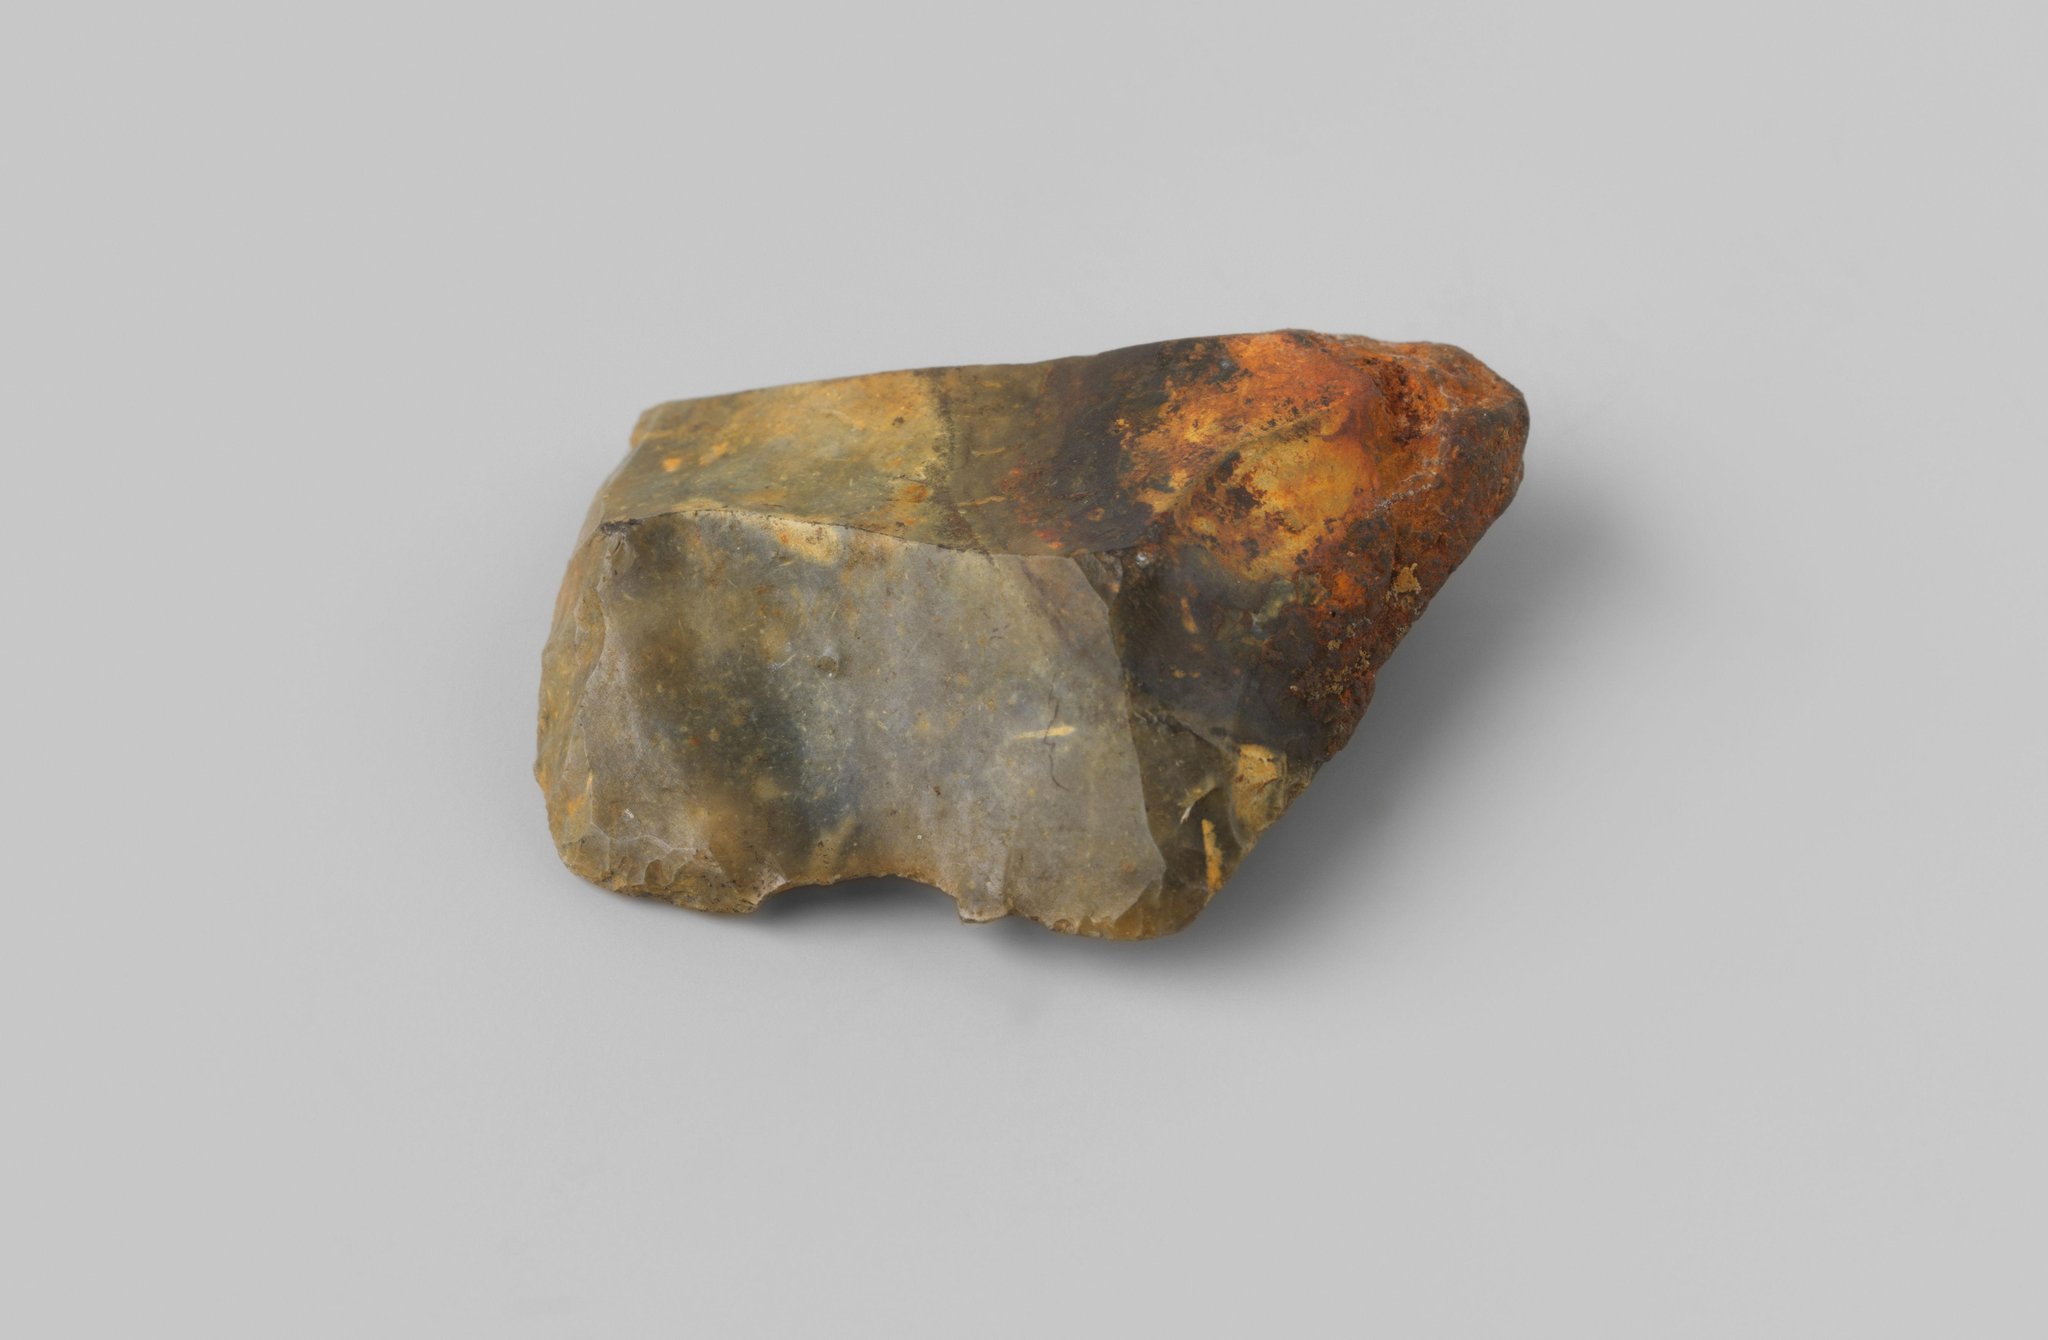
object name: gunflint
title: Vuursteen van een handwapen uit het wrak van de Oost-Indiëvaarder Hollandia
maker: Anonymous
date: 1700-1743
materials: stone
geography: netherlands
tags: verenigde oostindische compagnie, hollandia (schip), annet